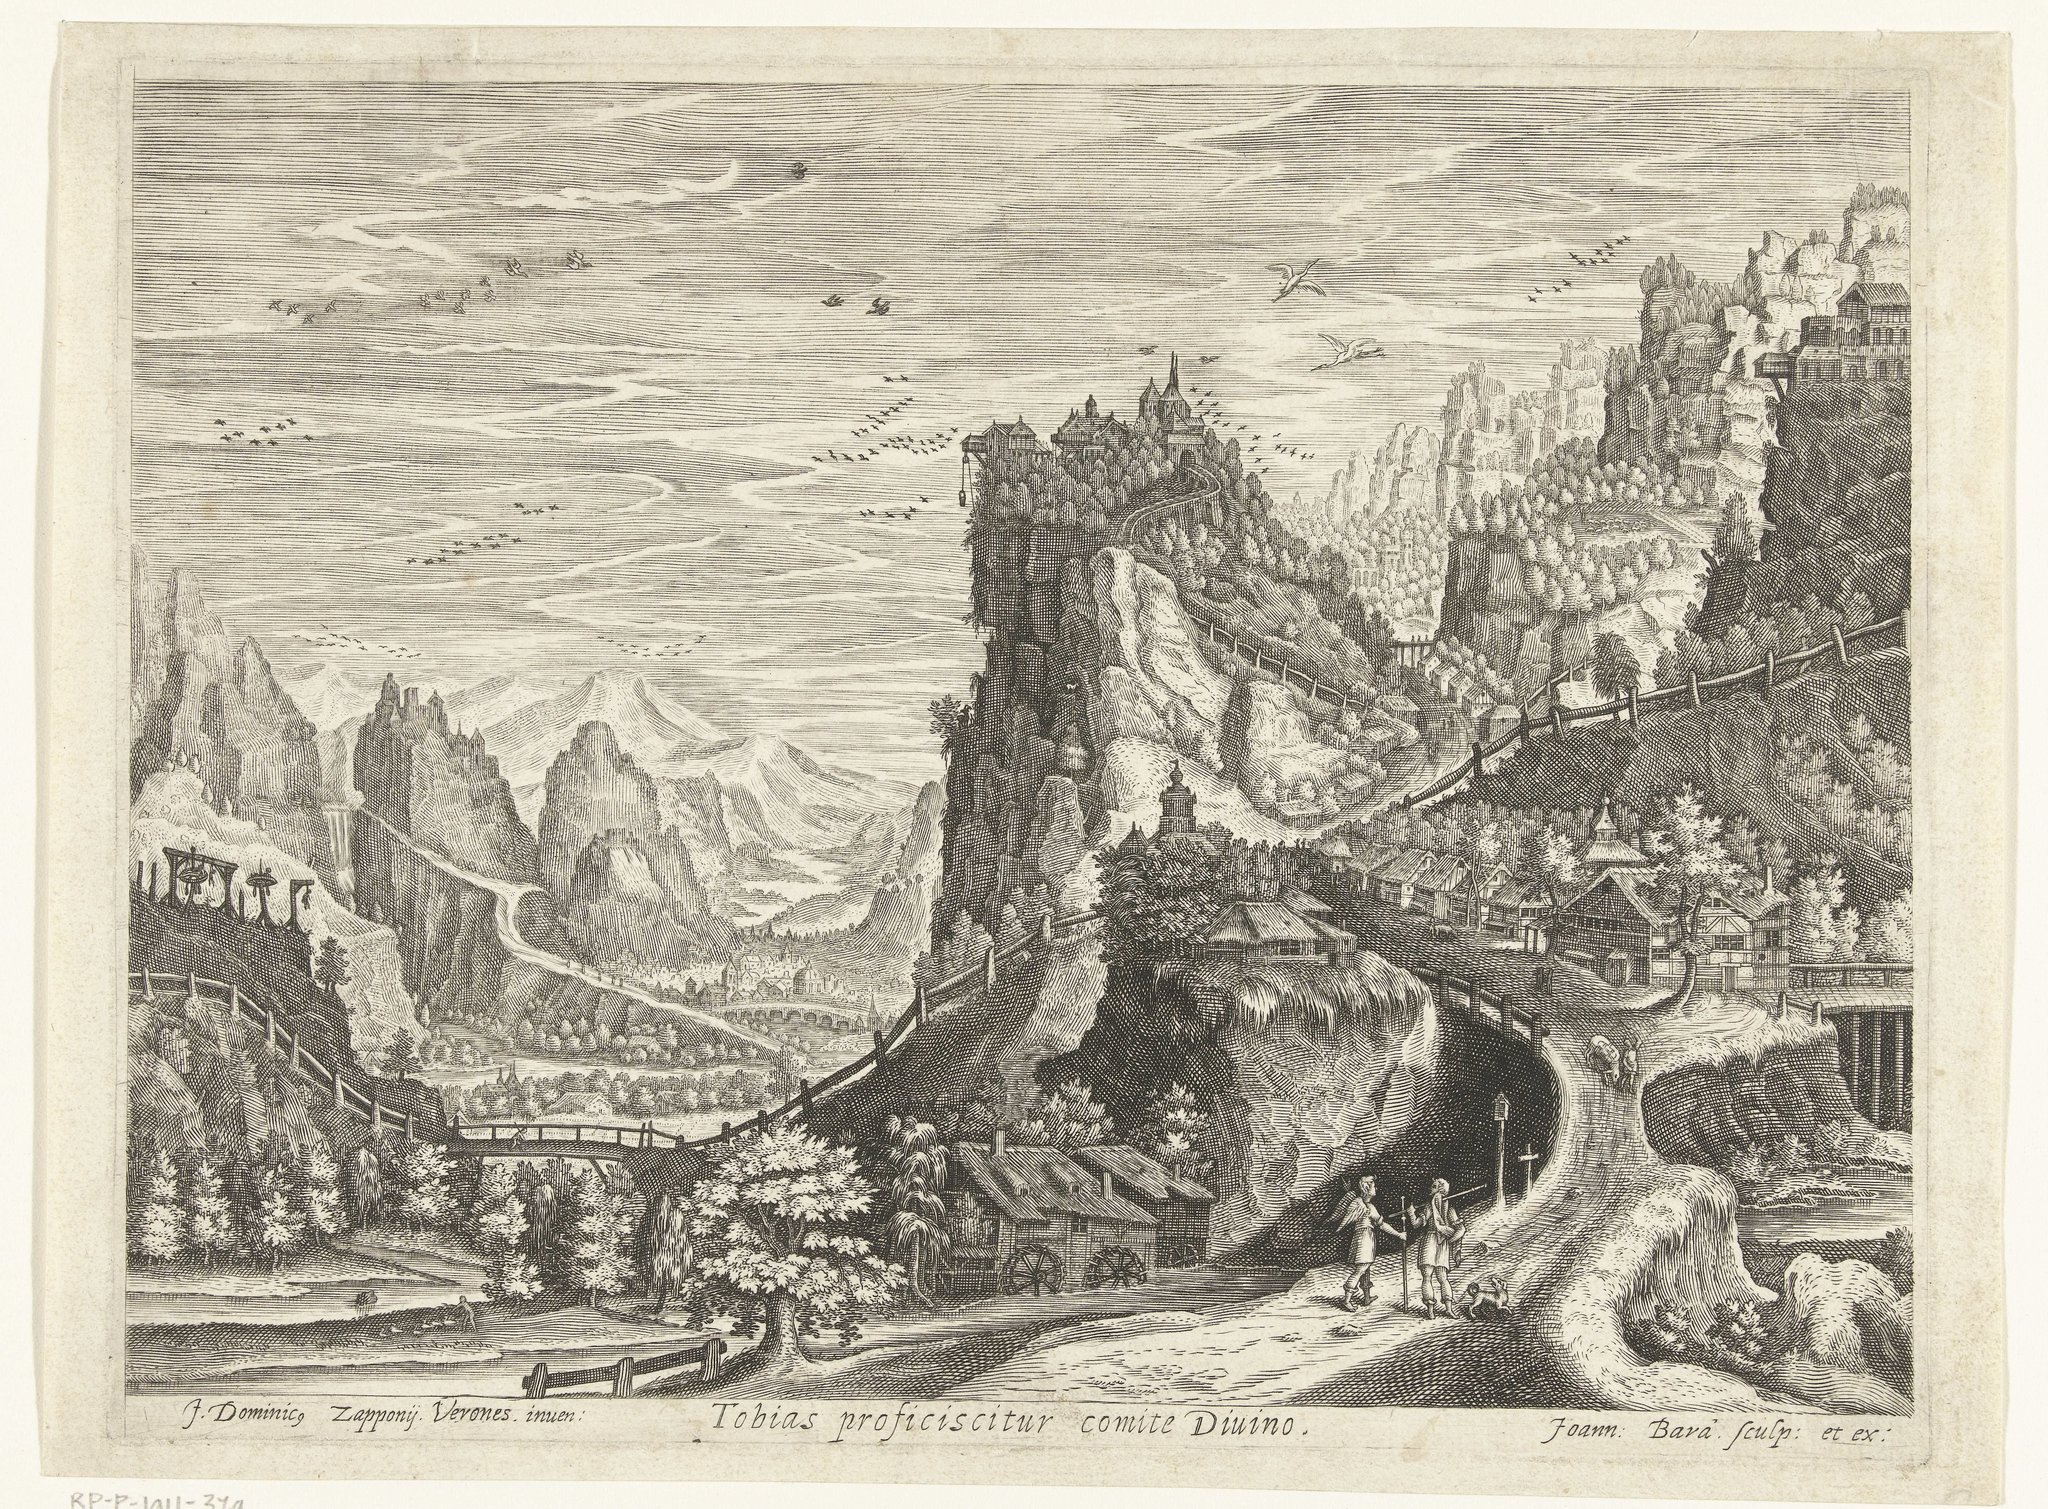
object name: print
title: Verhaal van Tobias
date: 1591-1634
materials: paper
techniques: engraving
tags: tobias and the angel raphael travelling, accompanied by tobias' dog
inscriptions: collector's mark: Lugt 2228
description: Prent naar ontwerp van Giovanni Domenico Zapponi. Prent maakt deel uit van serie met vier prenten over het verhaal van Tobias.